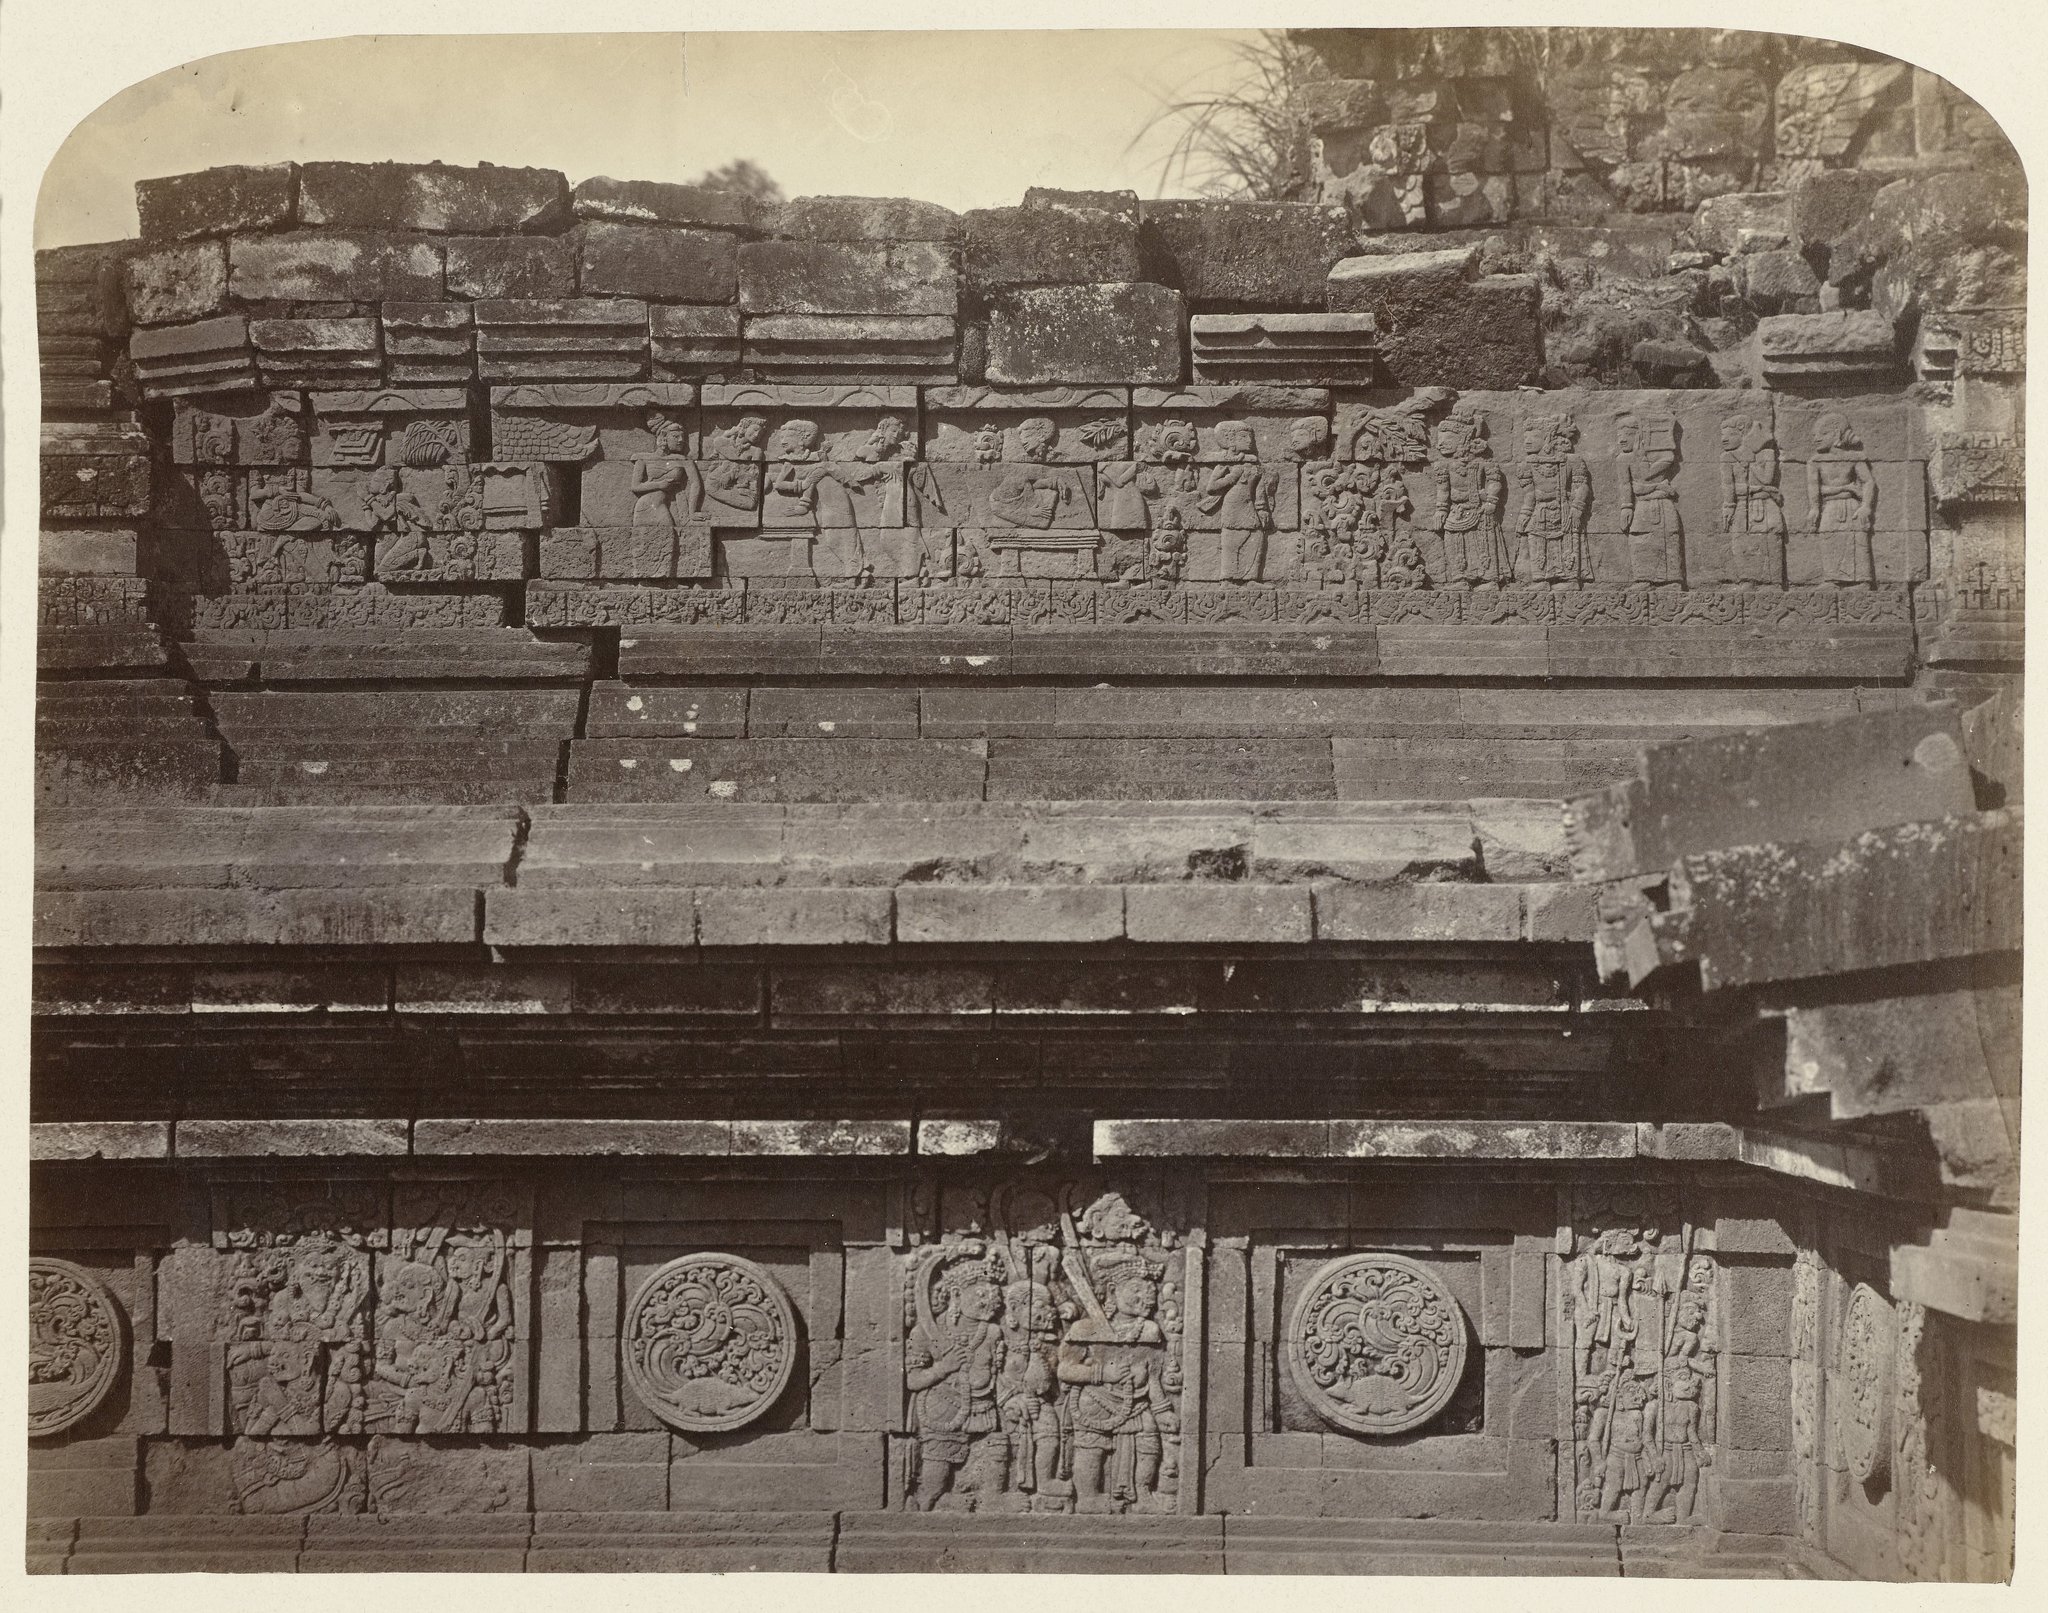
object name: photograph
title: Basreliëf van den tempel (oostzijde) 1e gaanderij. Panataran (r. Kediri)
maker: isidore kinsbergen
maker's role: fotograaf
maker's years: 1821-1905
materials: cardboard, paper, photographic support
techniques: albumen print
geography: java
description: Candi Panataran (Temple Complex), main Temple; Ramayana reliefs and Krishnayana relief no 15, east side. Panataran, Blitar district, East Java province 1323-1347 AD.